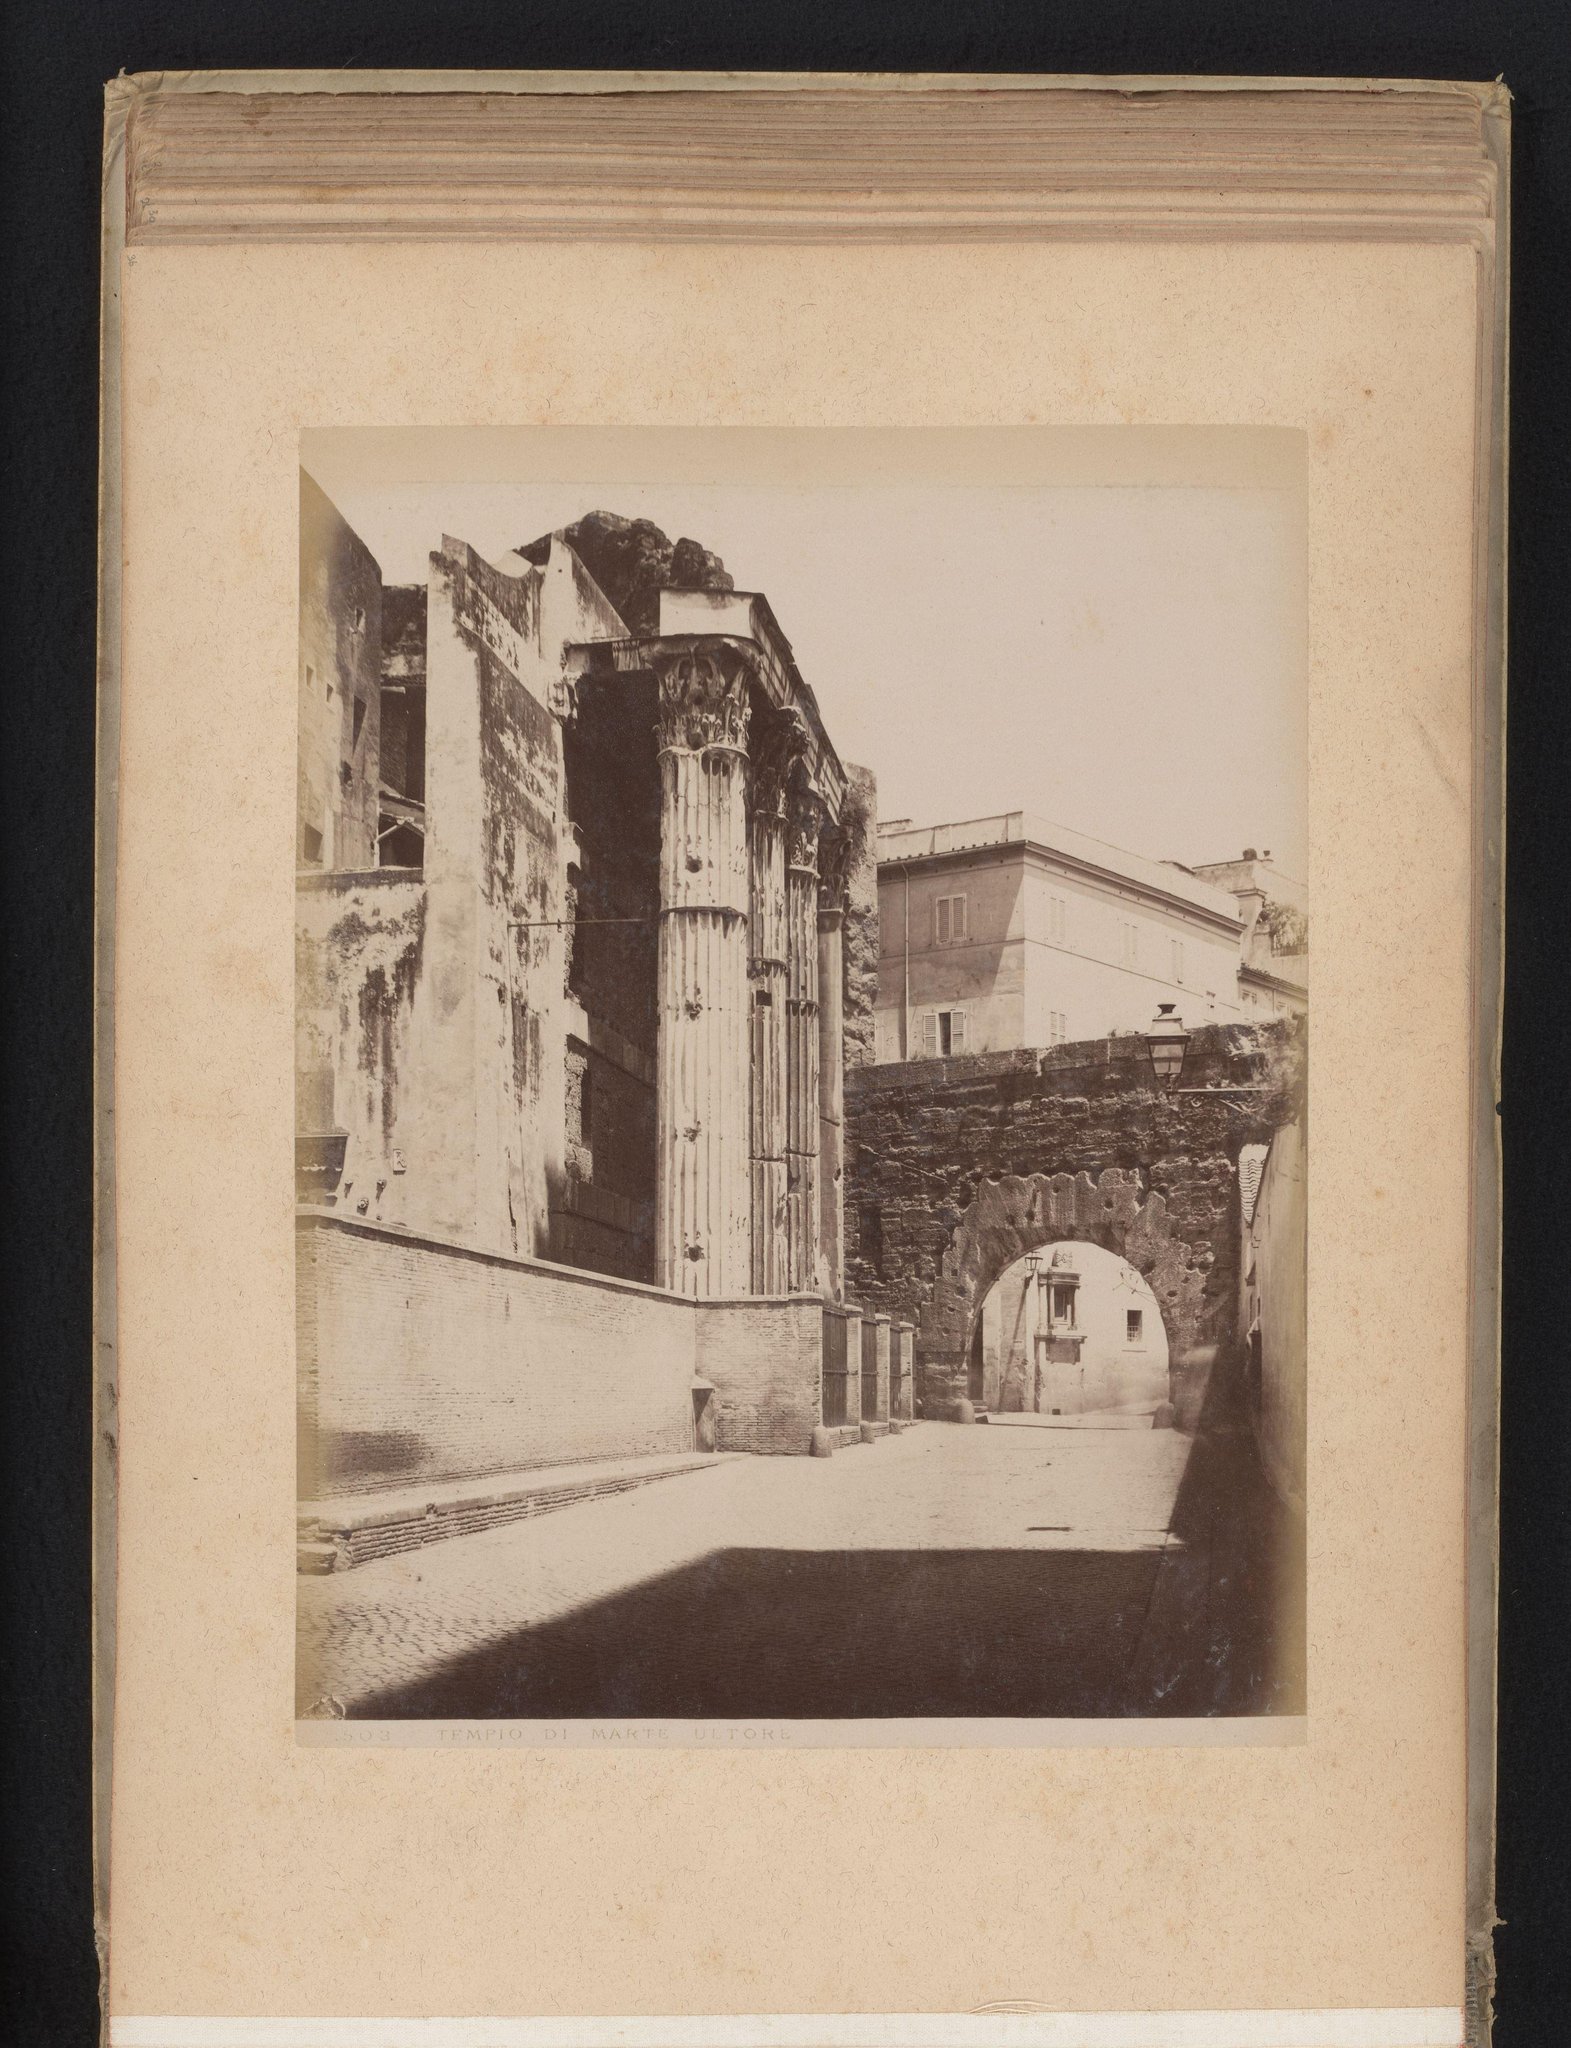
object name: album leaf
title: Gezicht op de tempel van Mars Ultor op het Forum van Augustus in Rome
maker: Anonymous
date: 1870-1895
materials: cardboard, photographic support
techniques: albumen print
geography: rome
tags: (story of) mars (ares), ruin of a building ~ architecture, temple, shrine ~ roman religion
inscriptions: inscription: ‘503 TEMPLO DU MARTE ULTORE’